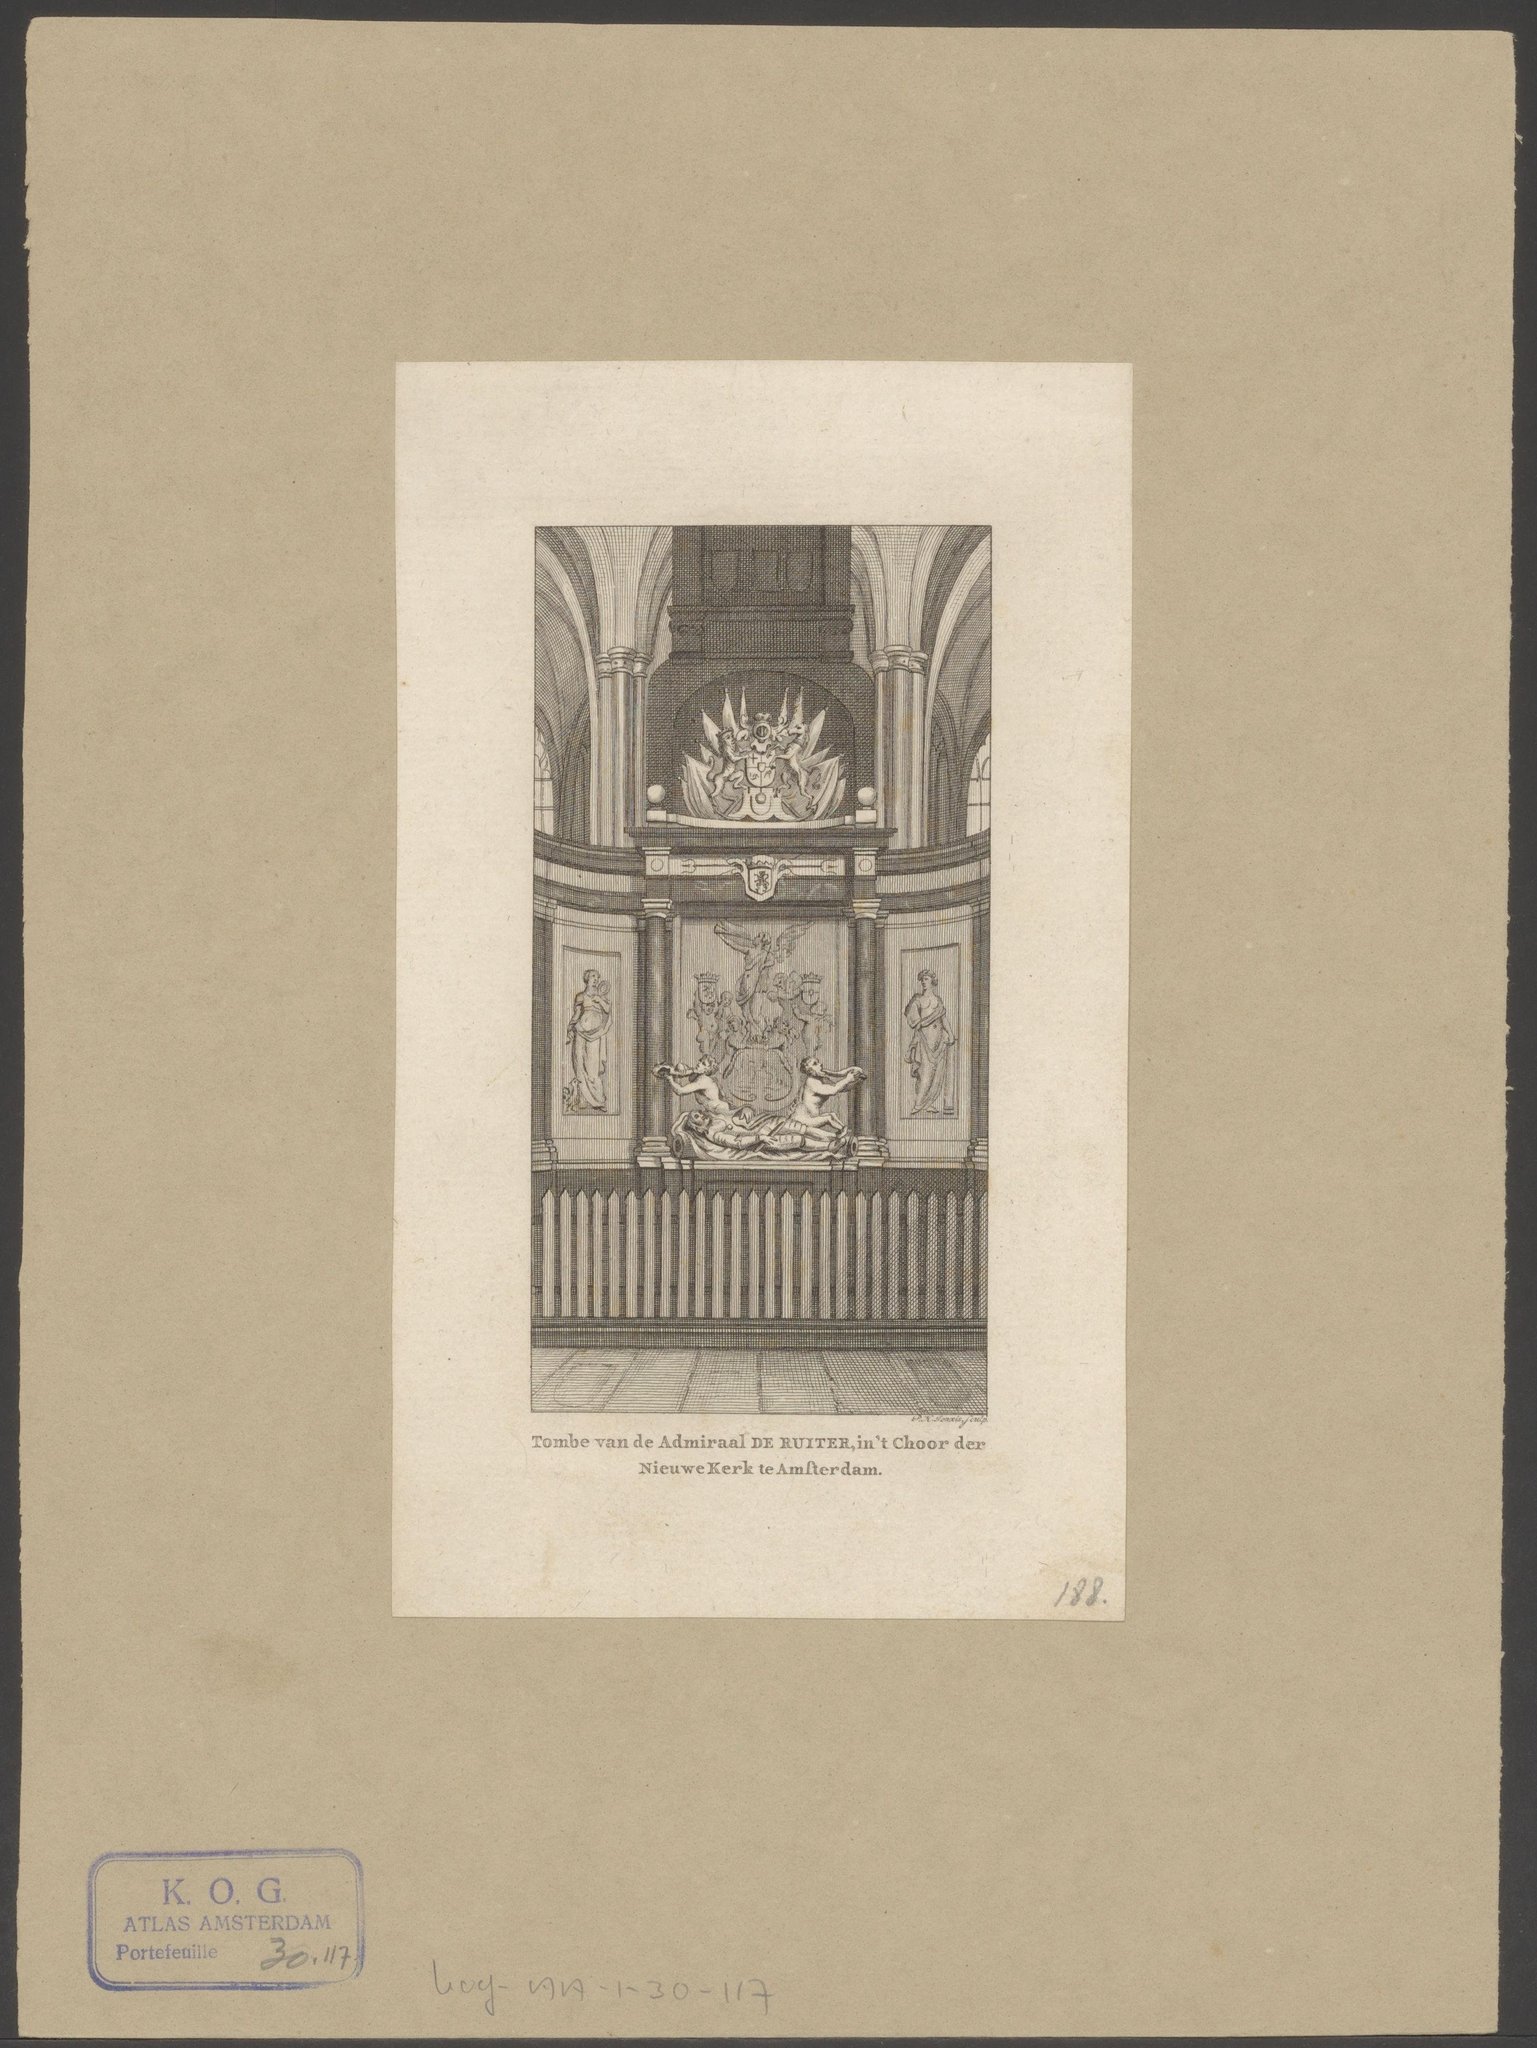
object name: print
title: Grafmonument van Michiel de Ruyter in de Nieuwe Kerk te Amsterdam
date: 1791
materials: paper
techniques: engraving, etching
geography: amsterdam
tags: michiel adriaenszoon de ruyter, grave-building, monumental tomb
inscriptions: collector's mark: Lugt 1641b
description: Onderwerpsrubriek binnen de Atlas Amsterdam: Kerkwezen: Hervormde Gemeente: Nieuwe Kerk van binnen.